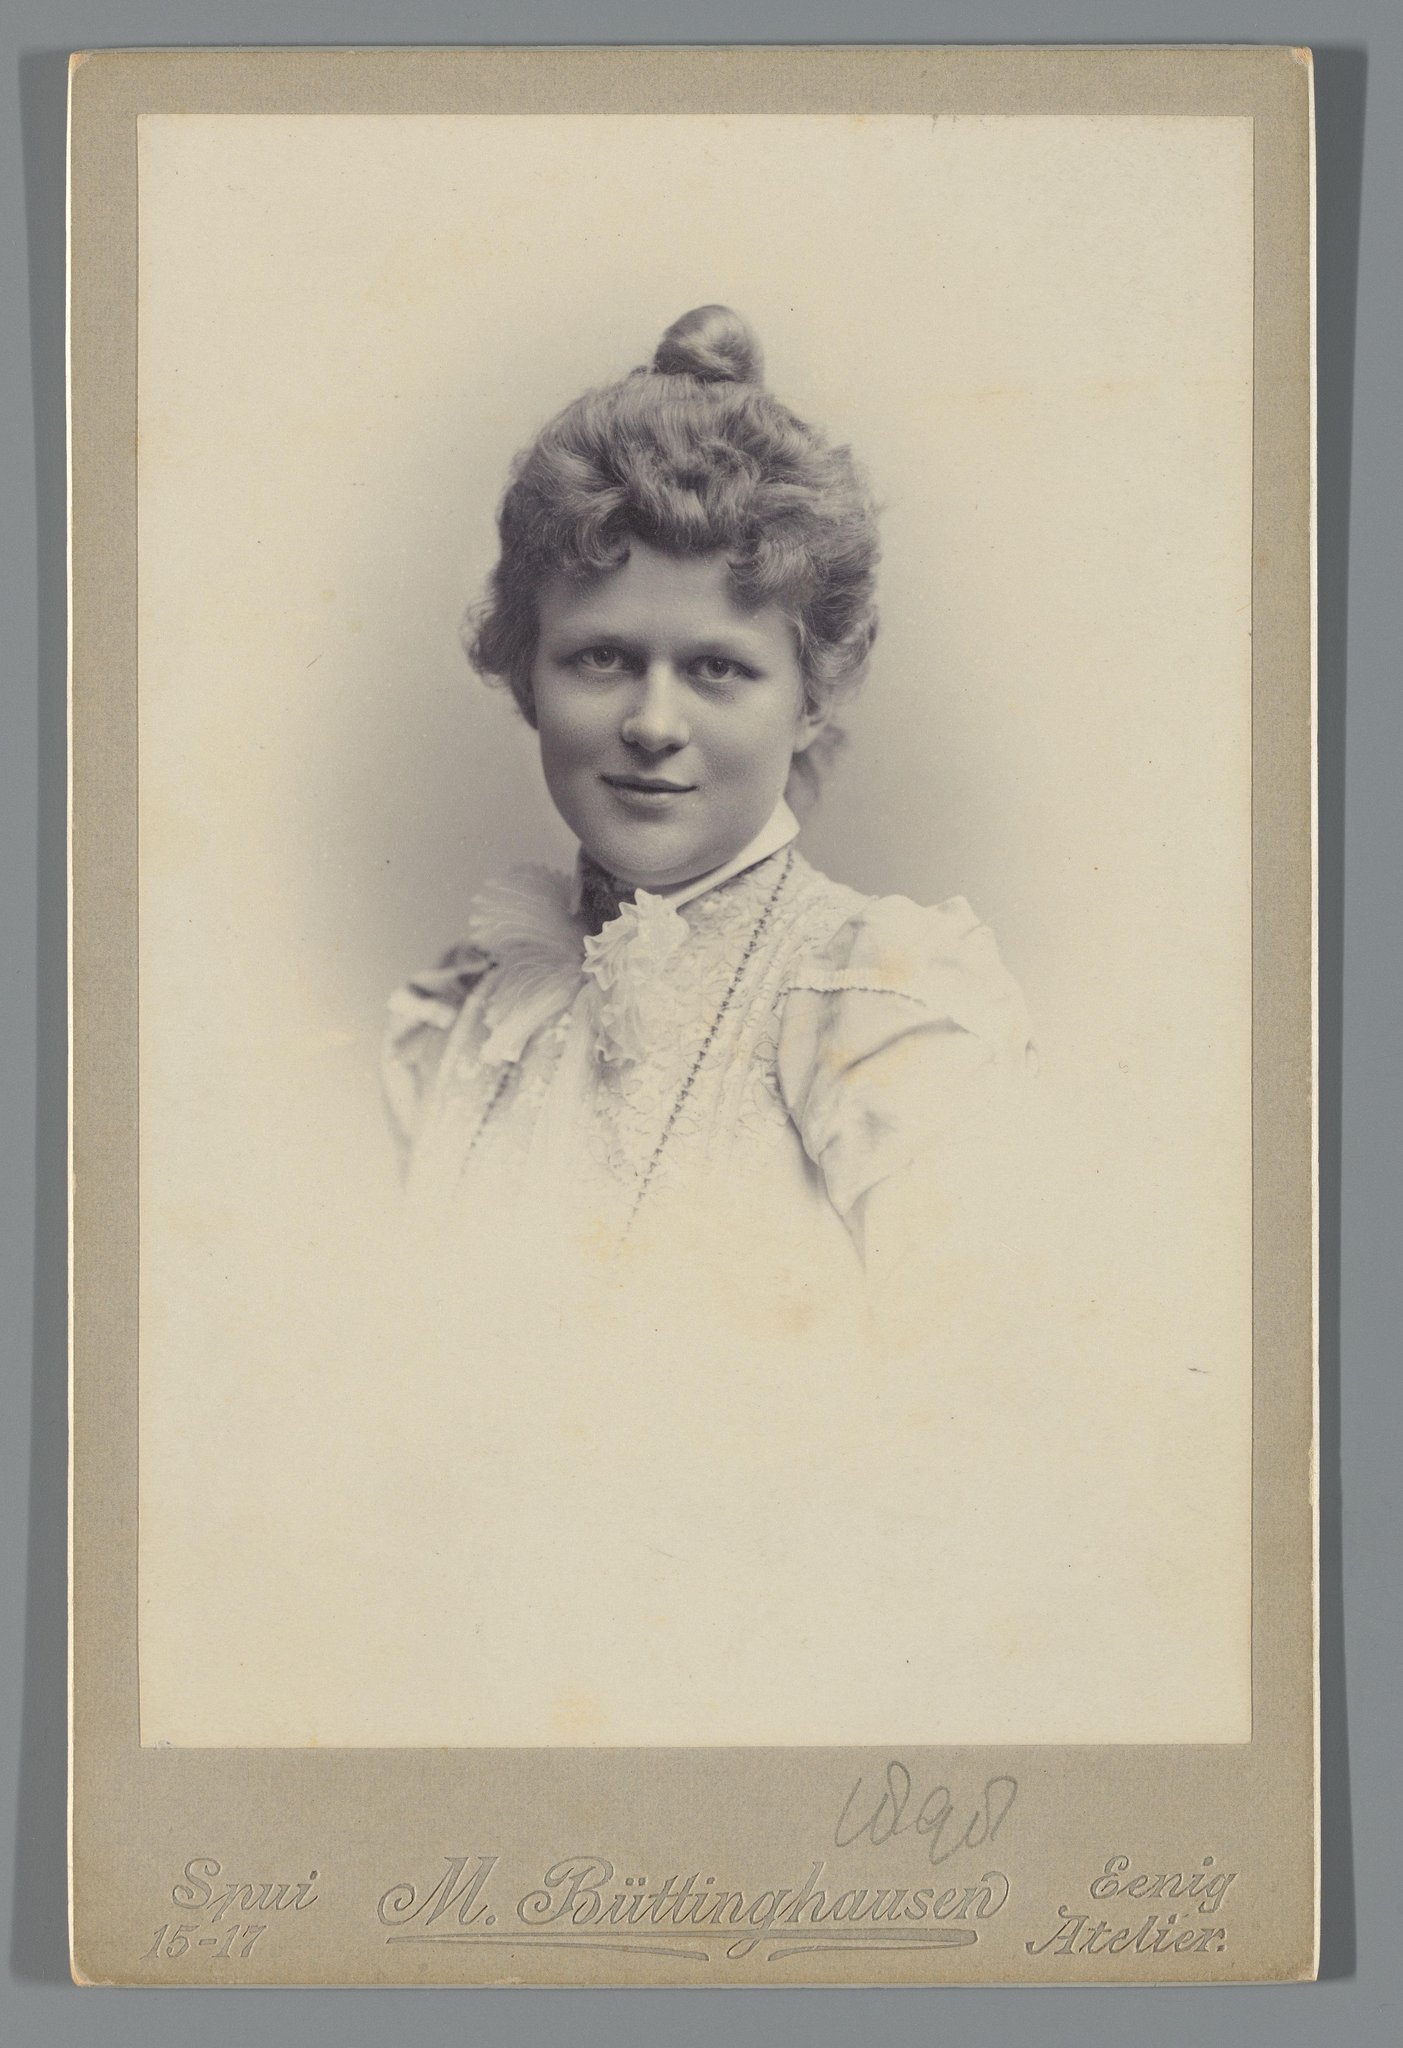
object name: cabinet photograph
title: Portret van Caroline L. van den Berg-Van den Berg (Line)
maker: max büttinghausen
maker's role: fotograaf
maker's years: 1847-1906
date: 1898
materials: cardboard, photographic support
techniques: albumen print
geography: spui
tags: the hague, caroline louise van den berg-van den berg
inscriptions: inscription: ‘Spui / 15 - 17 / M. Büttinghausen / Eenig / Atelier.’, date: ‘1898’